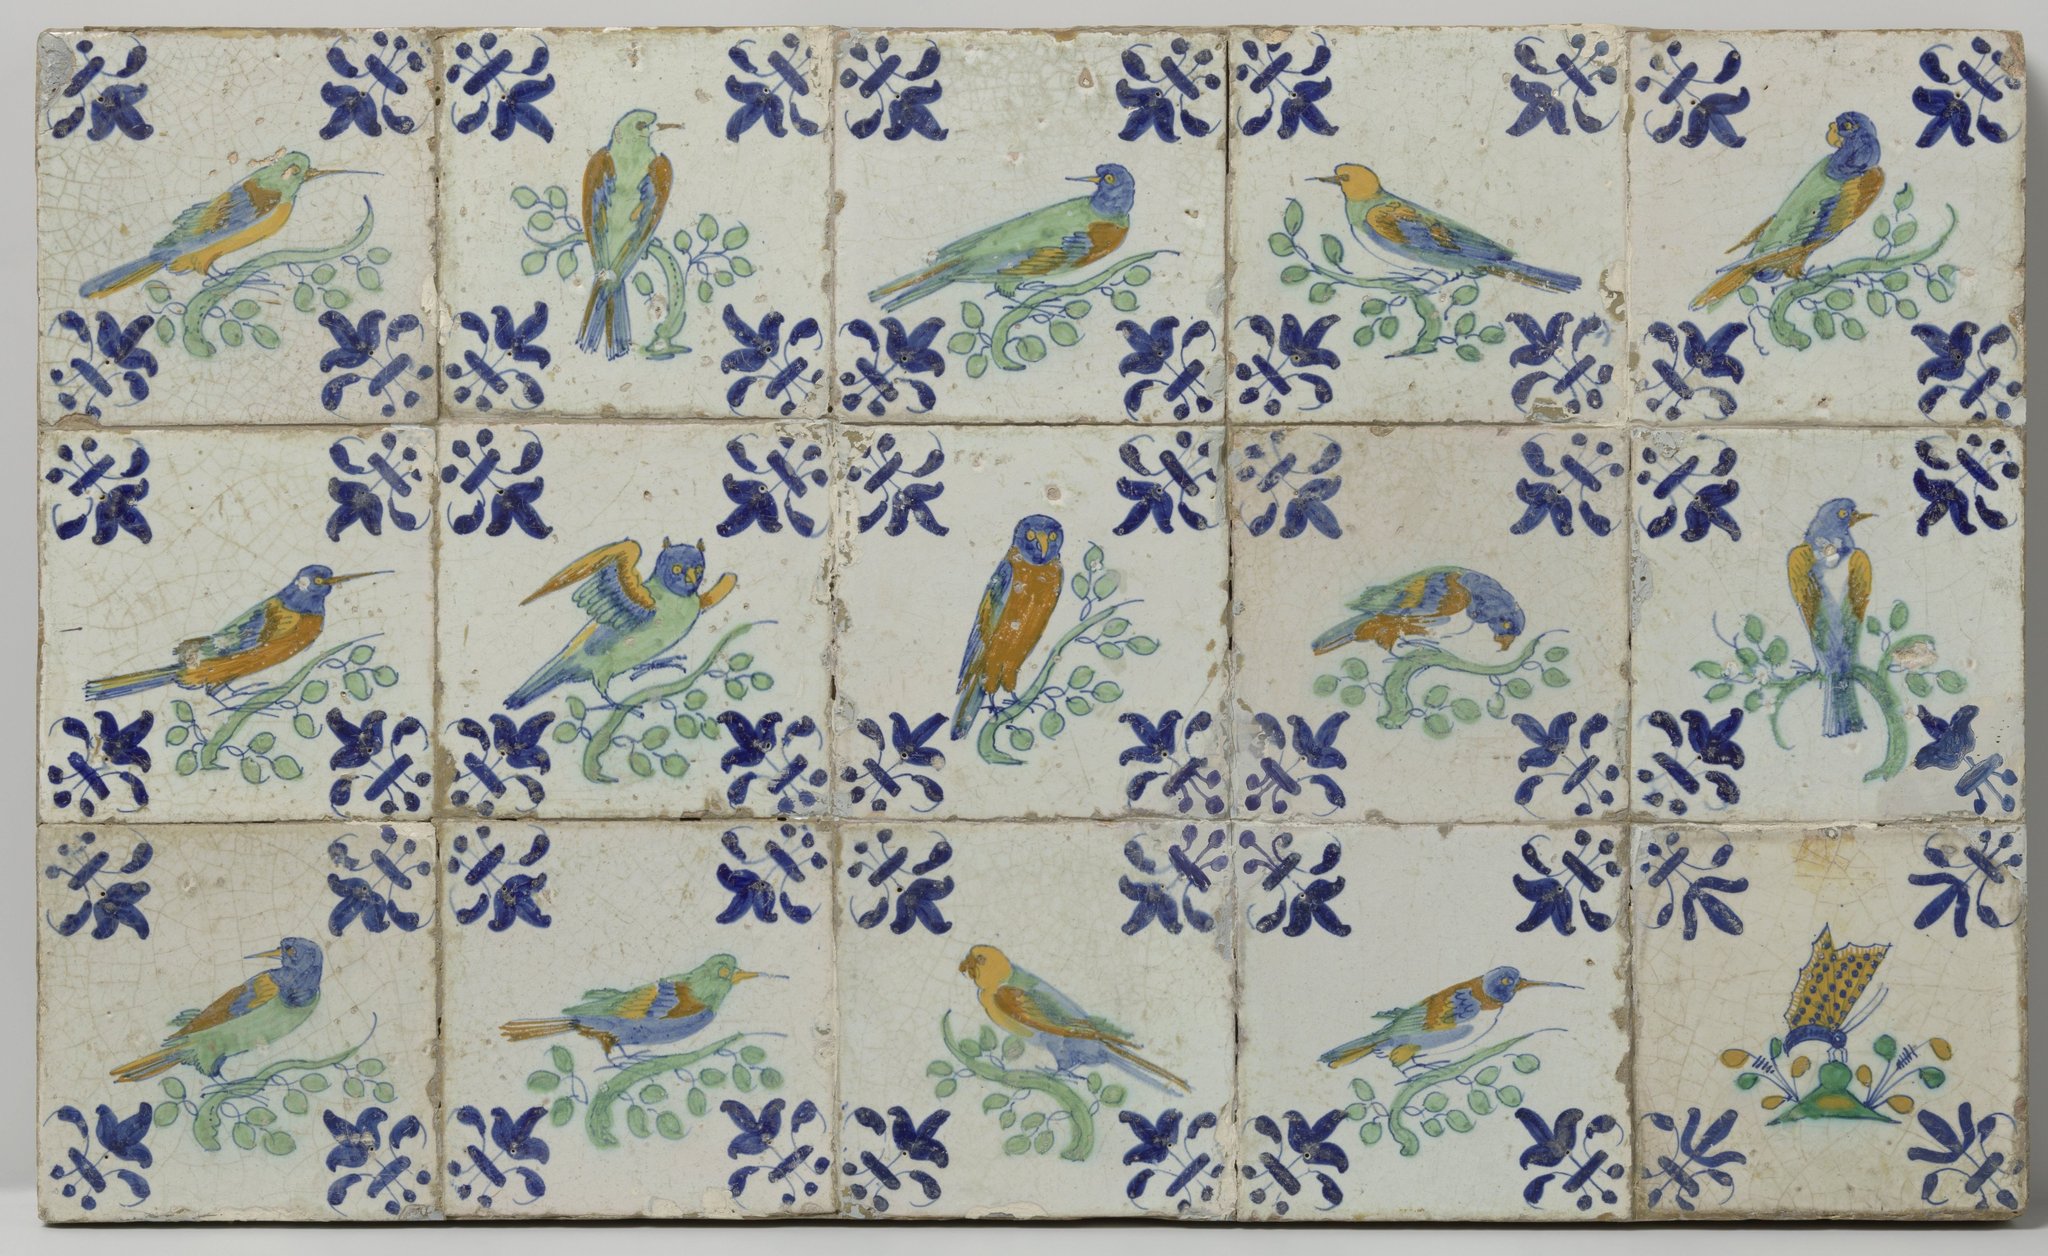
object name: vogeltegel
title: Veld van vijftien tegels met vogels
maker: Anonymous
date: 1640-1660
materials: earthenware, glaze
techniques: maiolica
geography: netherlands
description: Veld van vijftien tegels (3 x 5) elk met een veelkleurig (blauw, groen, geel en oranje) geschilderde vogel op een grond met in de hoeken een lelie.